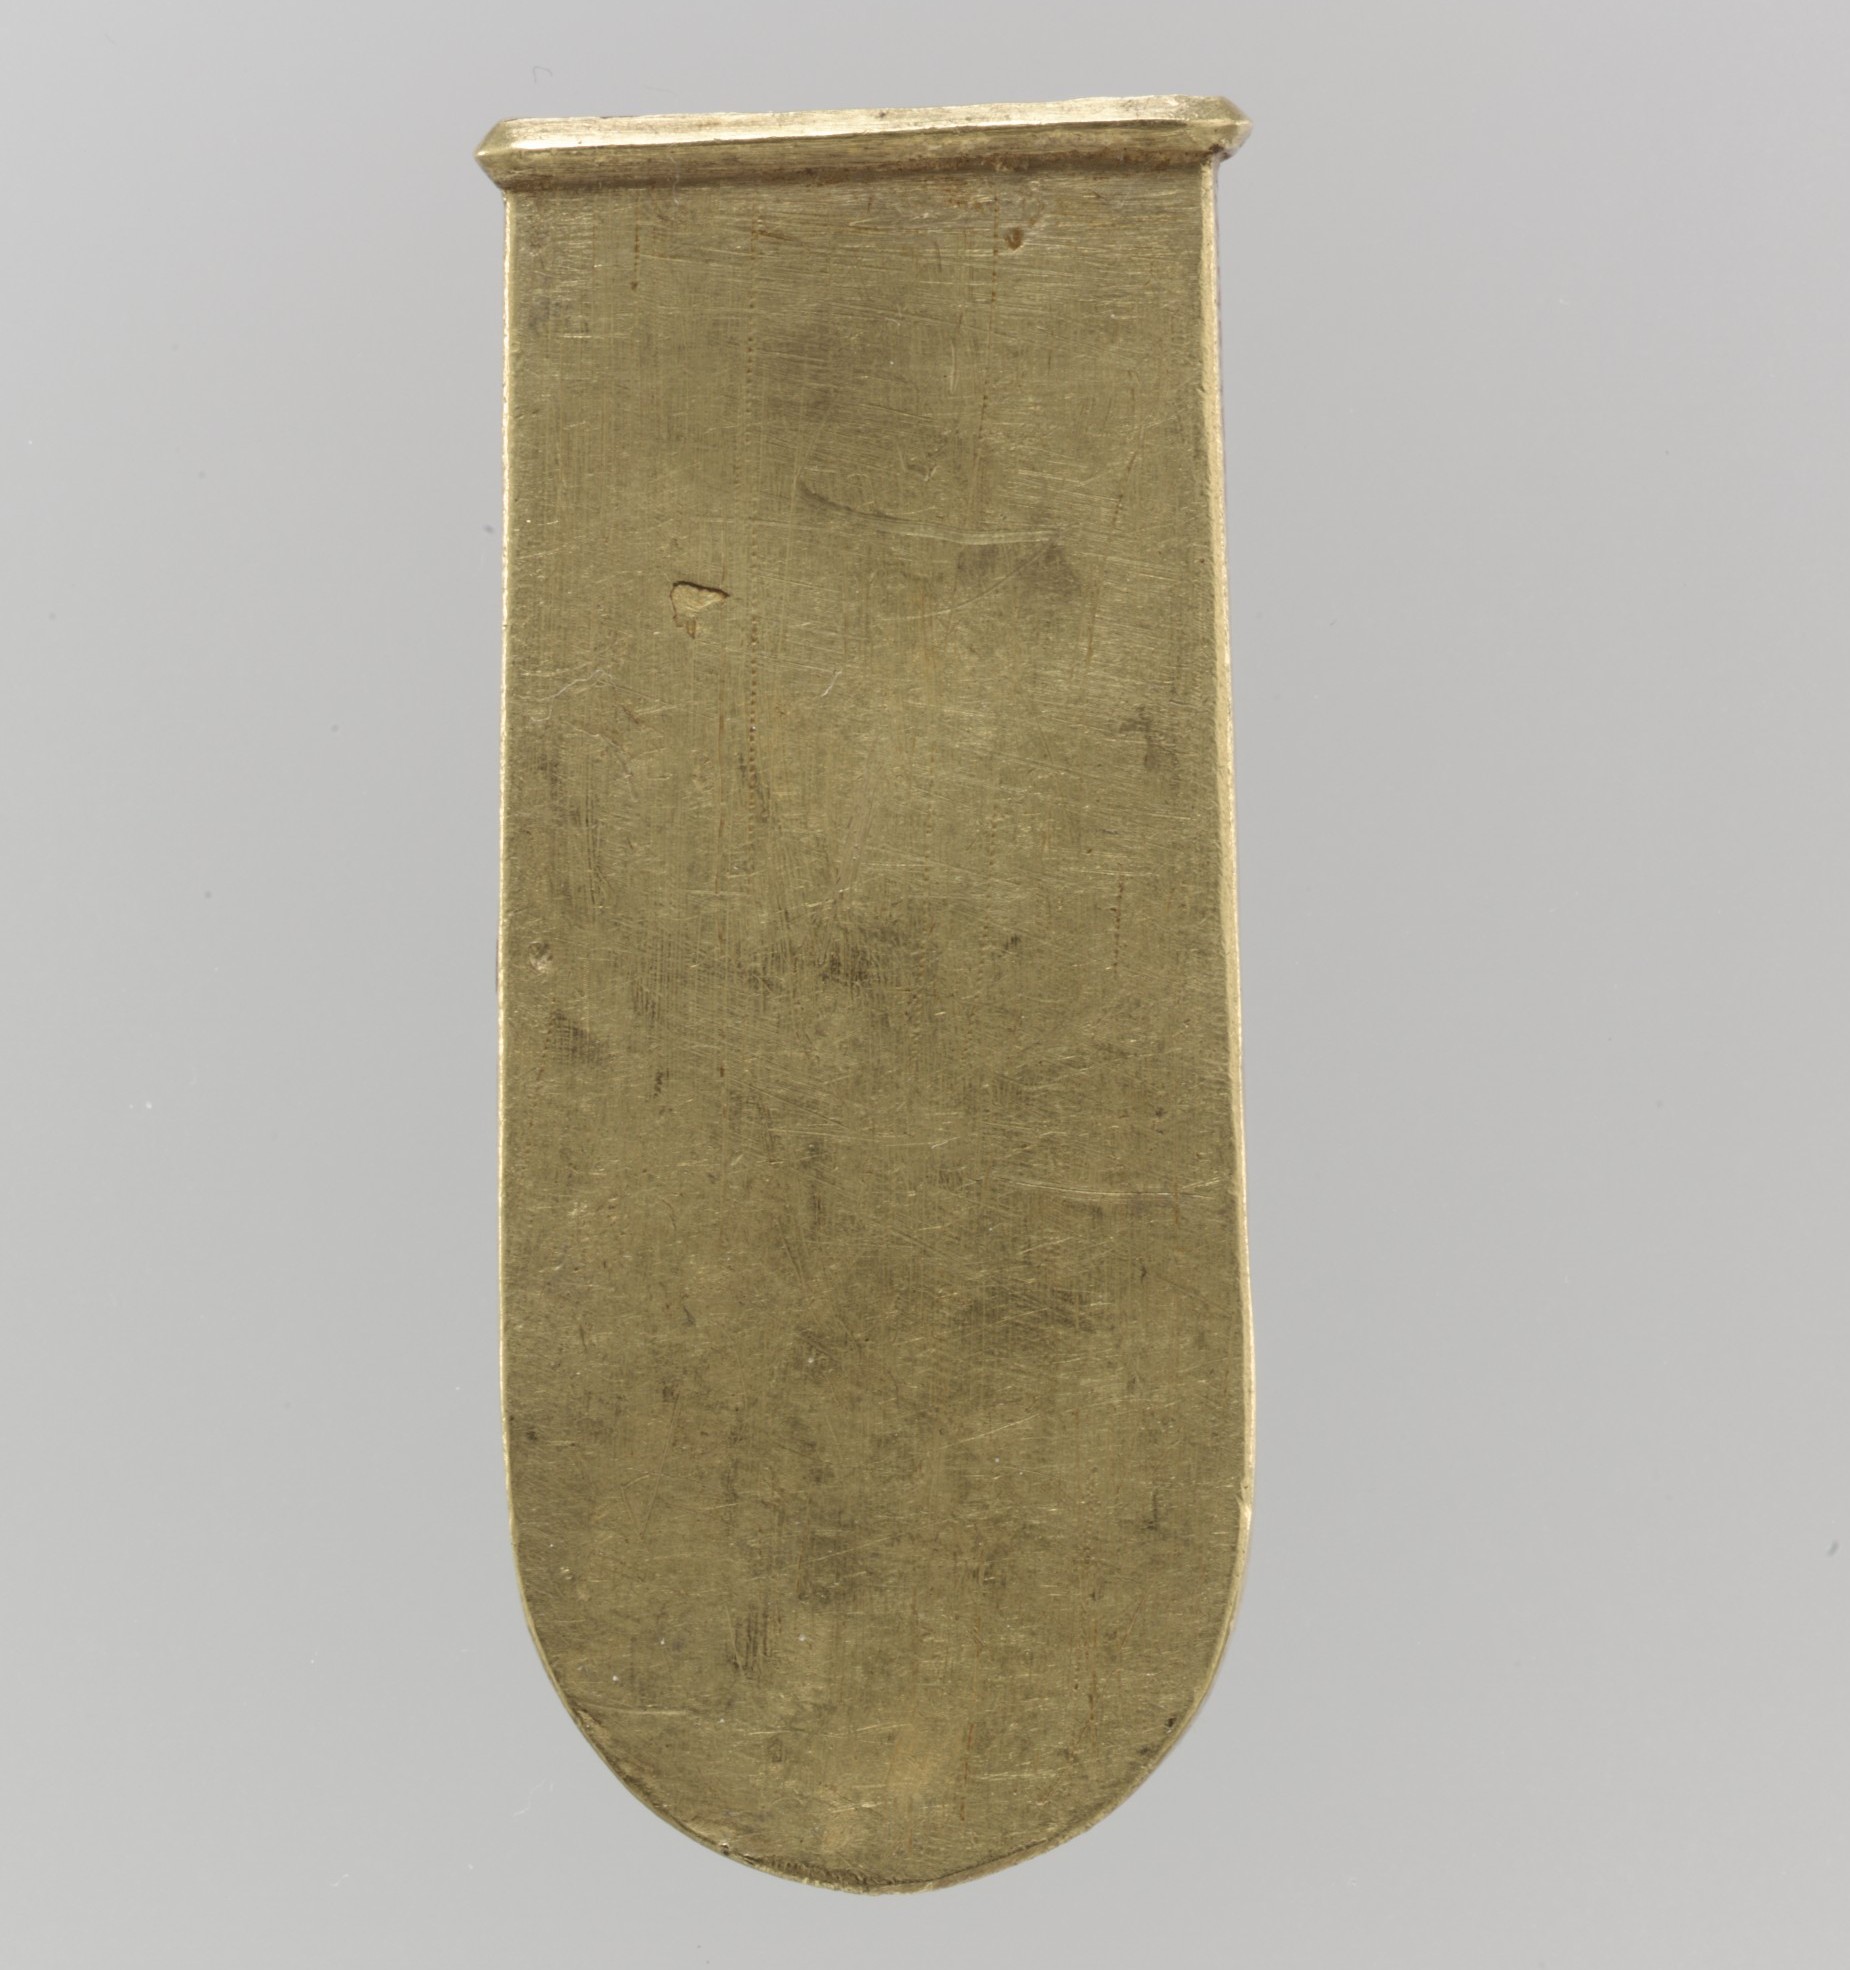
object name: strap end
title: Gold Strap End (Unfinished)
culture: avar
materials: gold